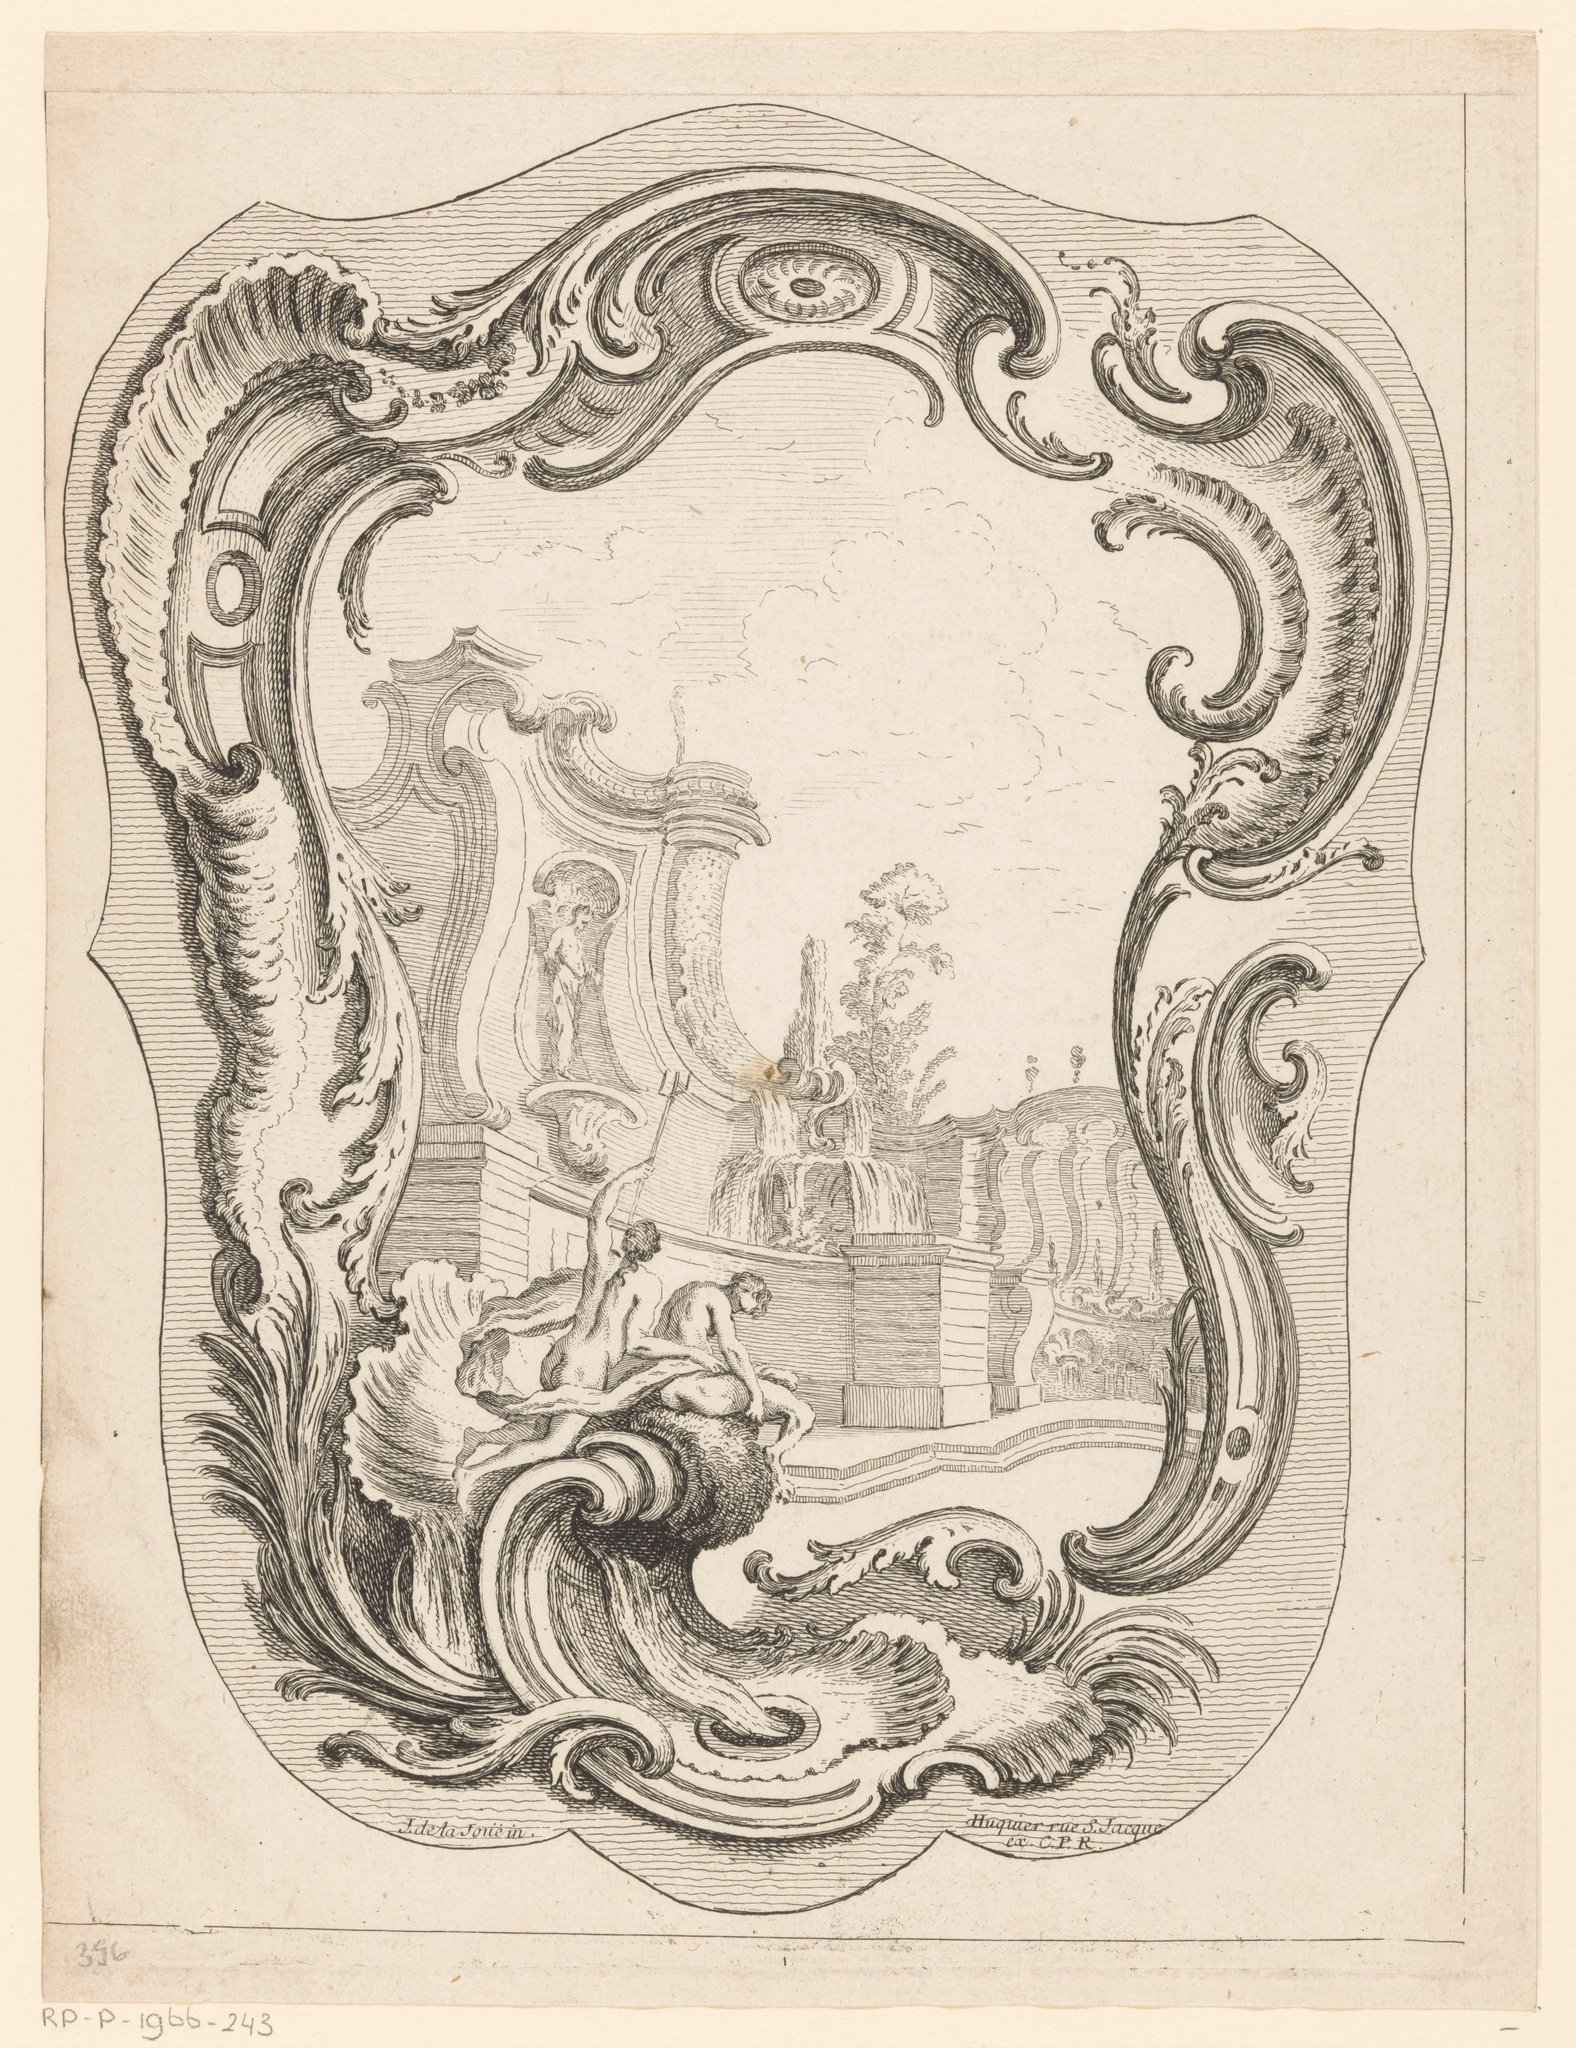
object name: print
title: Fontein met mannelijk figuur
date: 1738-1749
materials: paper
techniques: etching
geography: paris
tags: standing figure, ornamental fountain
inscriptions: collector's mark: Lugt 2228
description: Een fontein met rocaille ornamenten en een mannelijk figuur in een nis. Rondom een rocaille omlijsting met twee naakte figuren met een drietand.